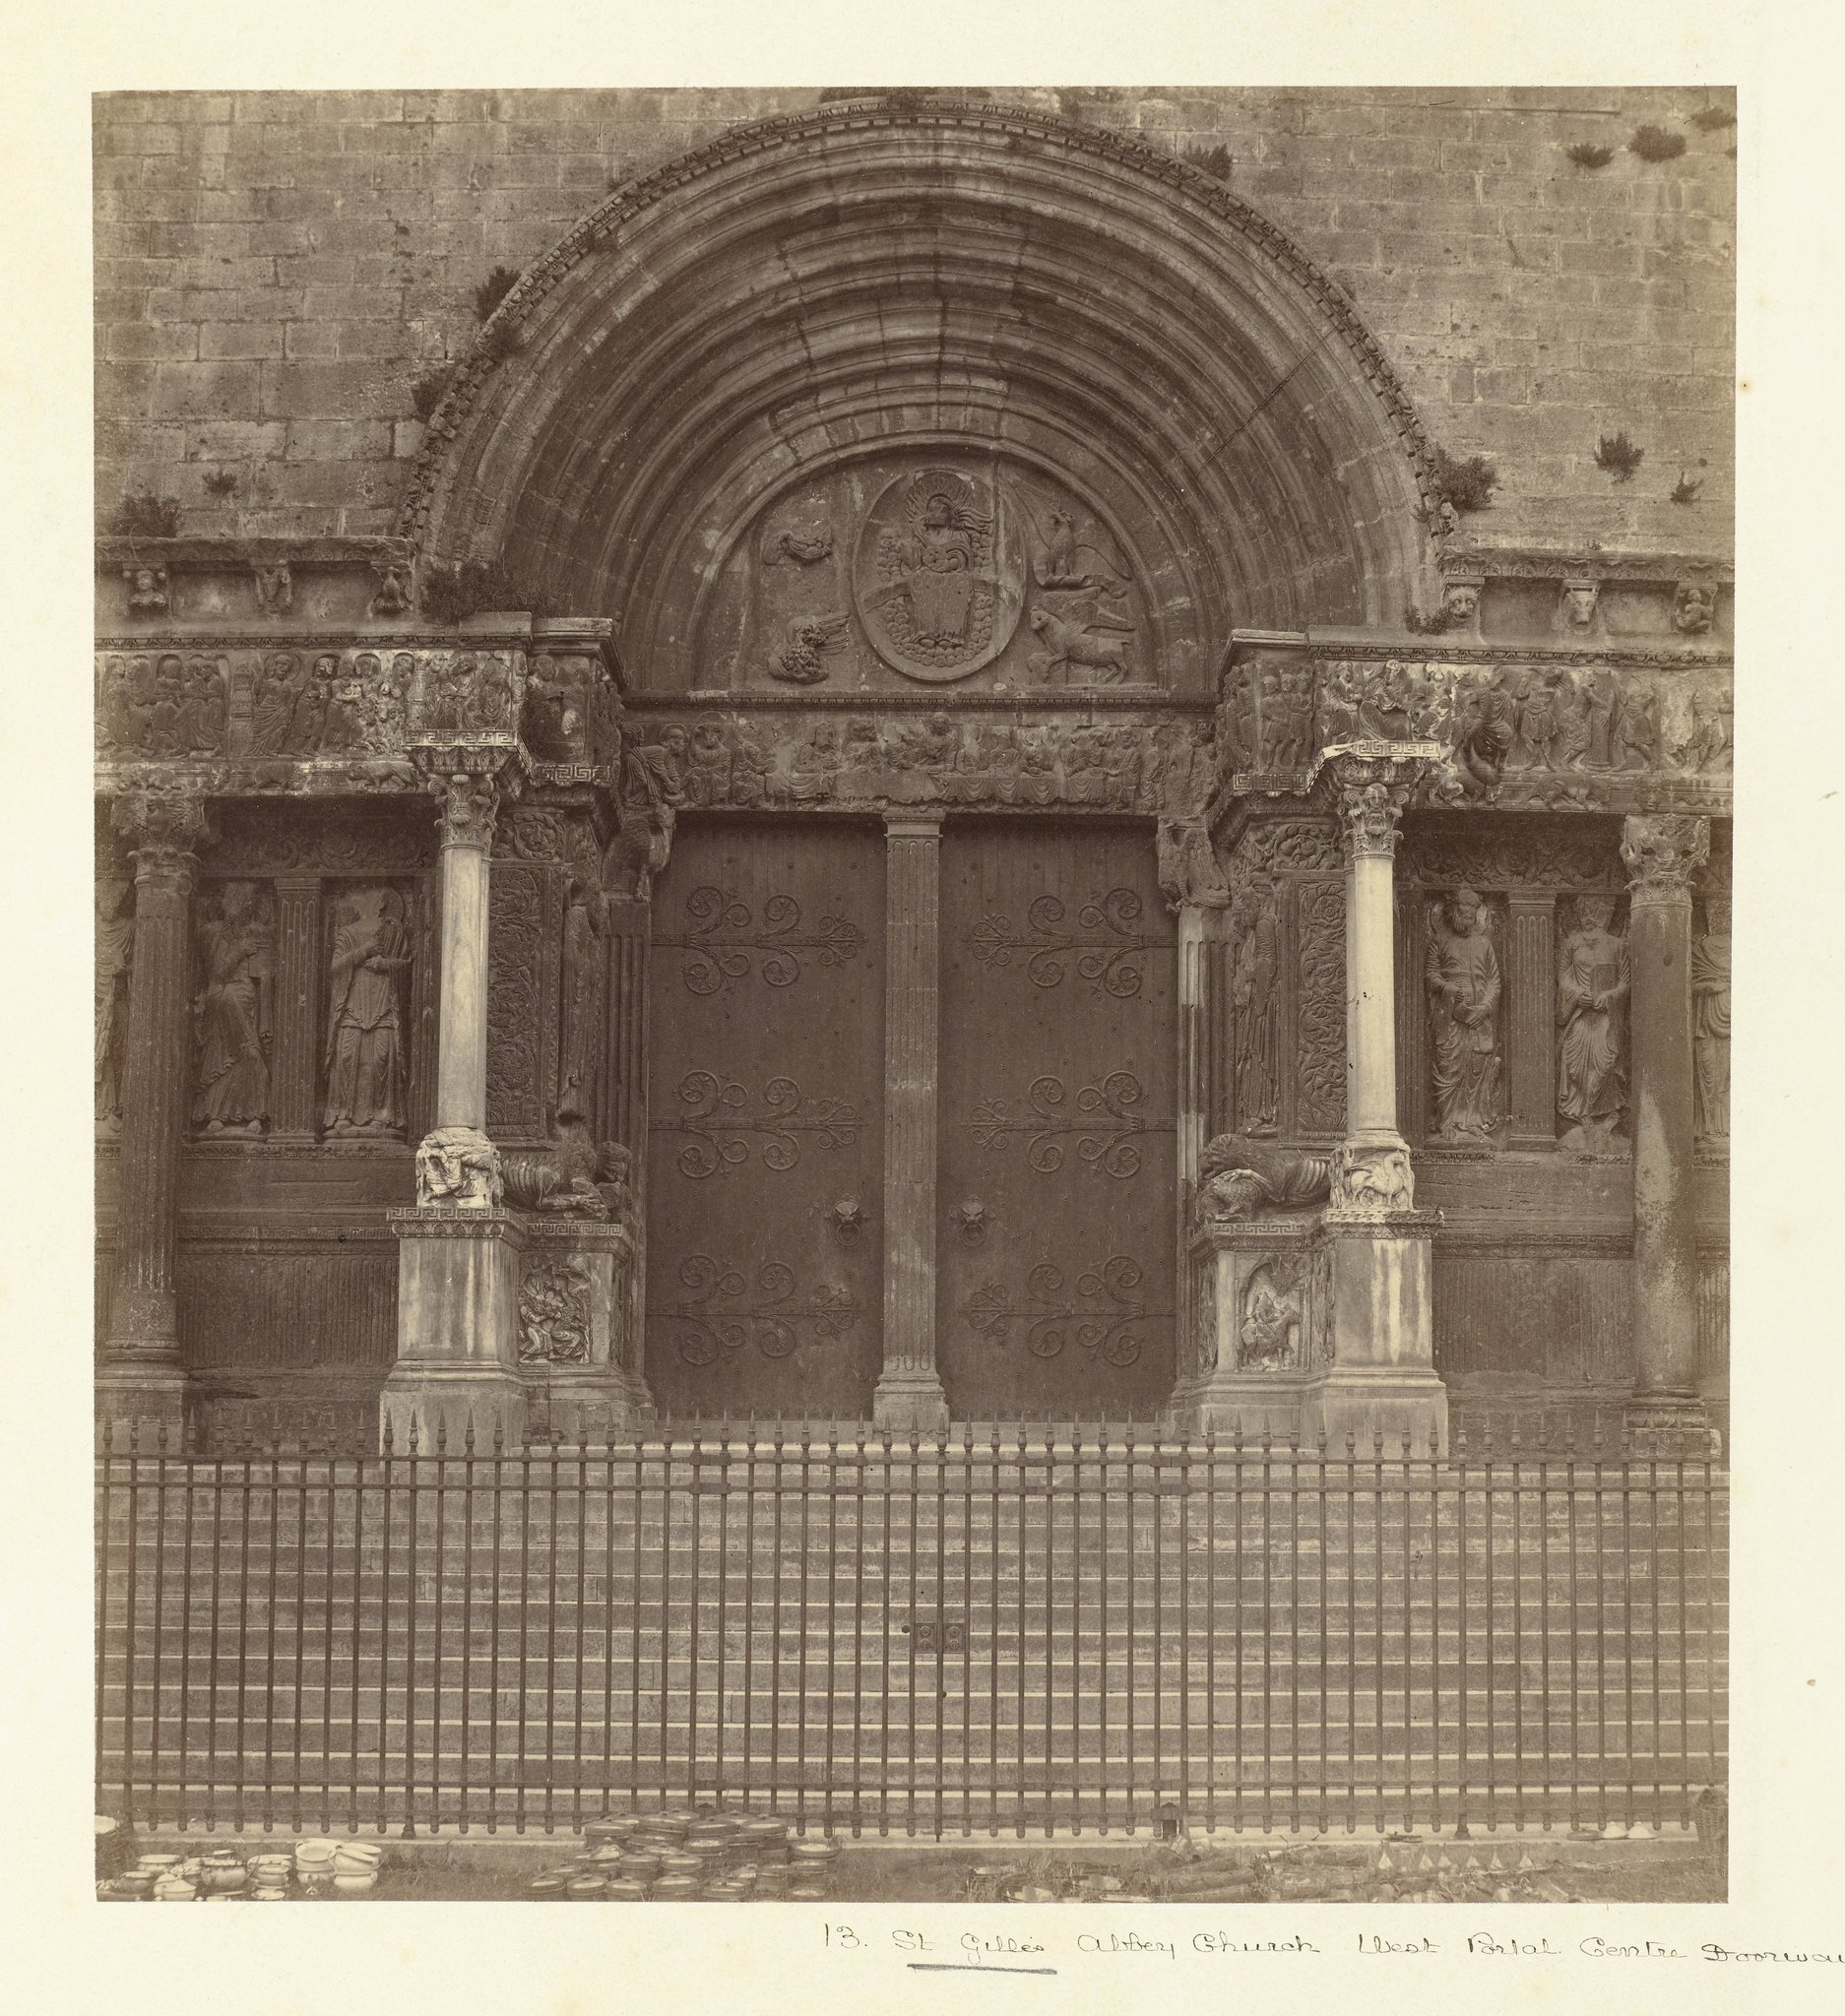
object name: photograph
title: St. Gilles Abbey Church, West Portal, Centre Doorway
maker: Anonymous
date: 1863-1865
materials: cardboard, paper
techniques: albumen print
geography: saint-gilles-du-gard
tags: parts of church exterior and annexes: portal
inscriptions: address: ‘168 NEW BOND ST.’